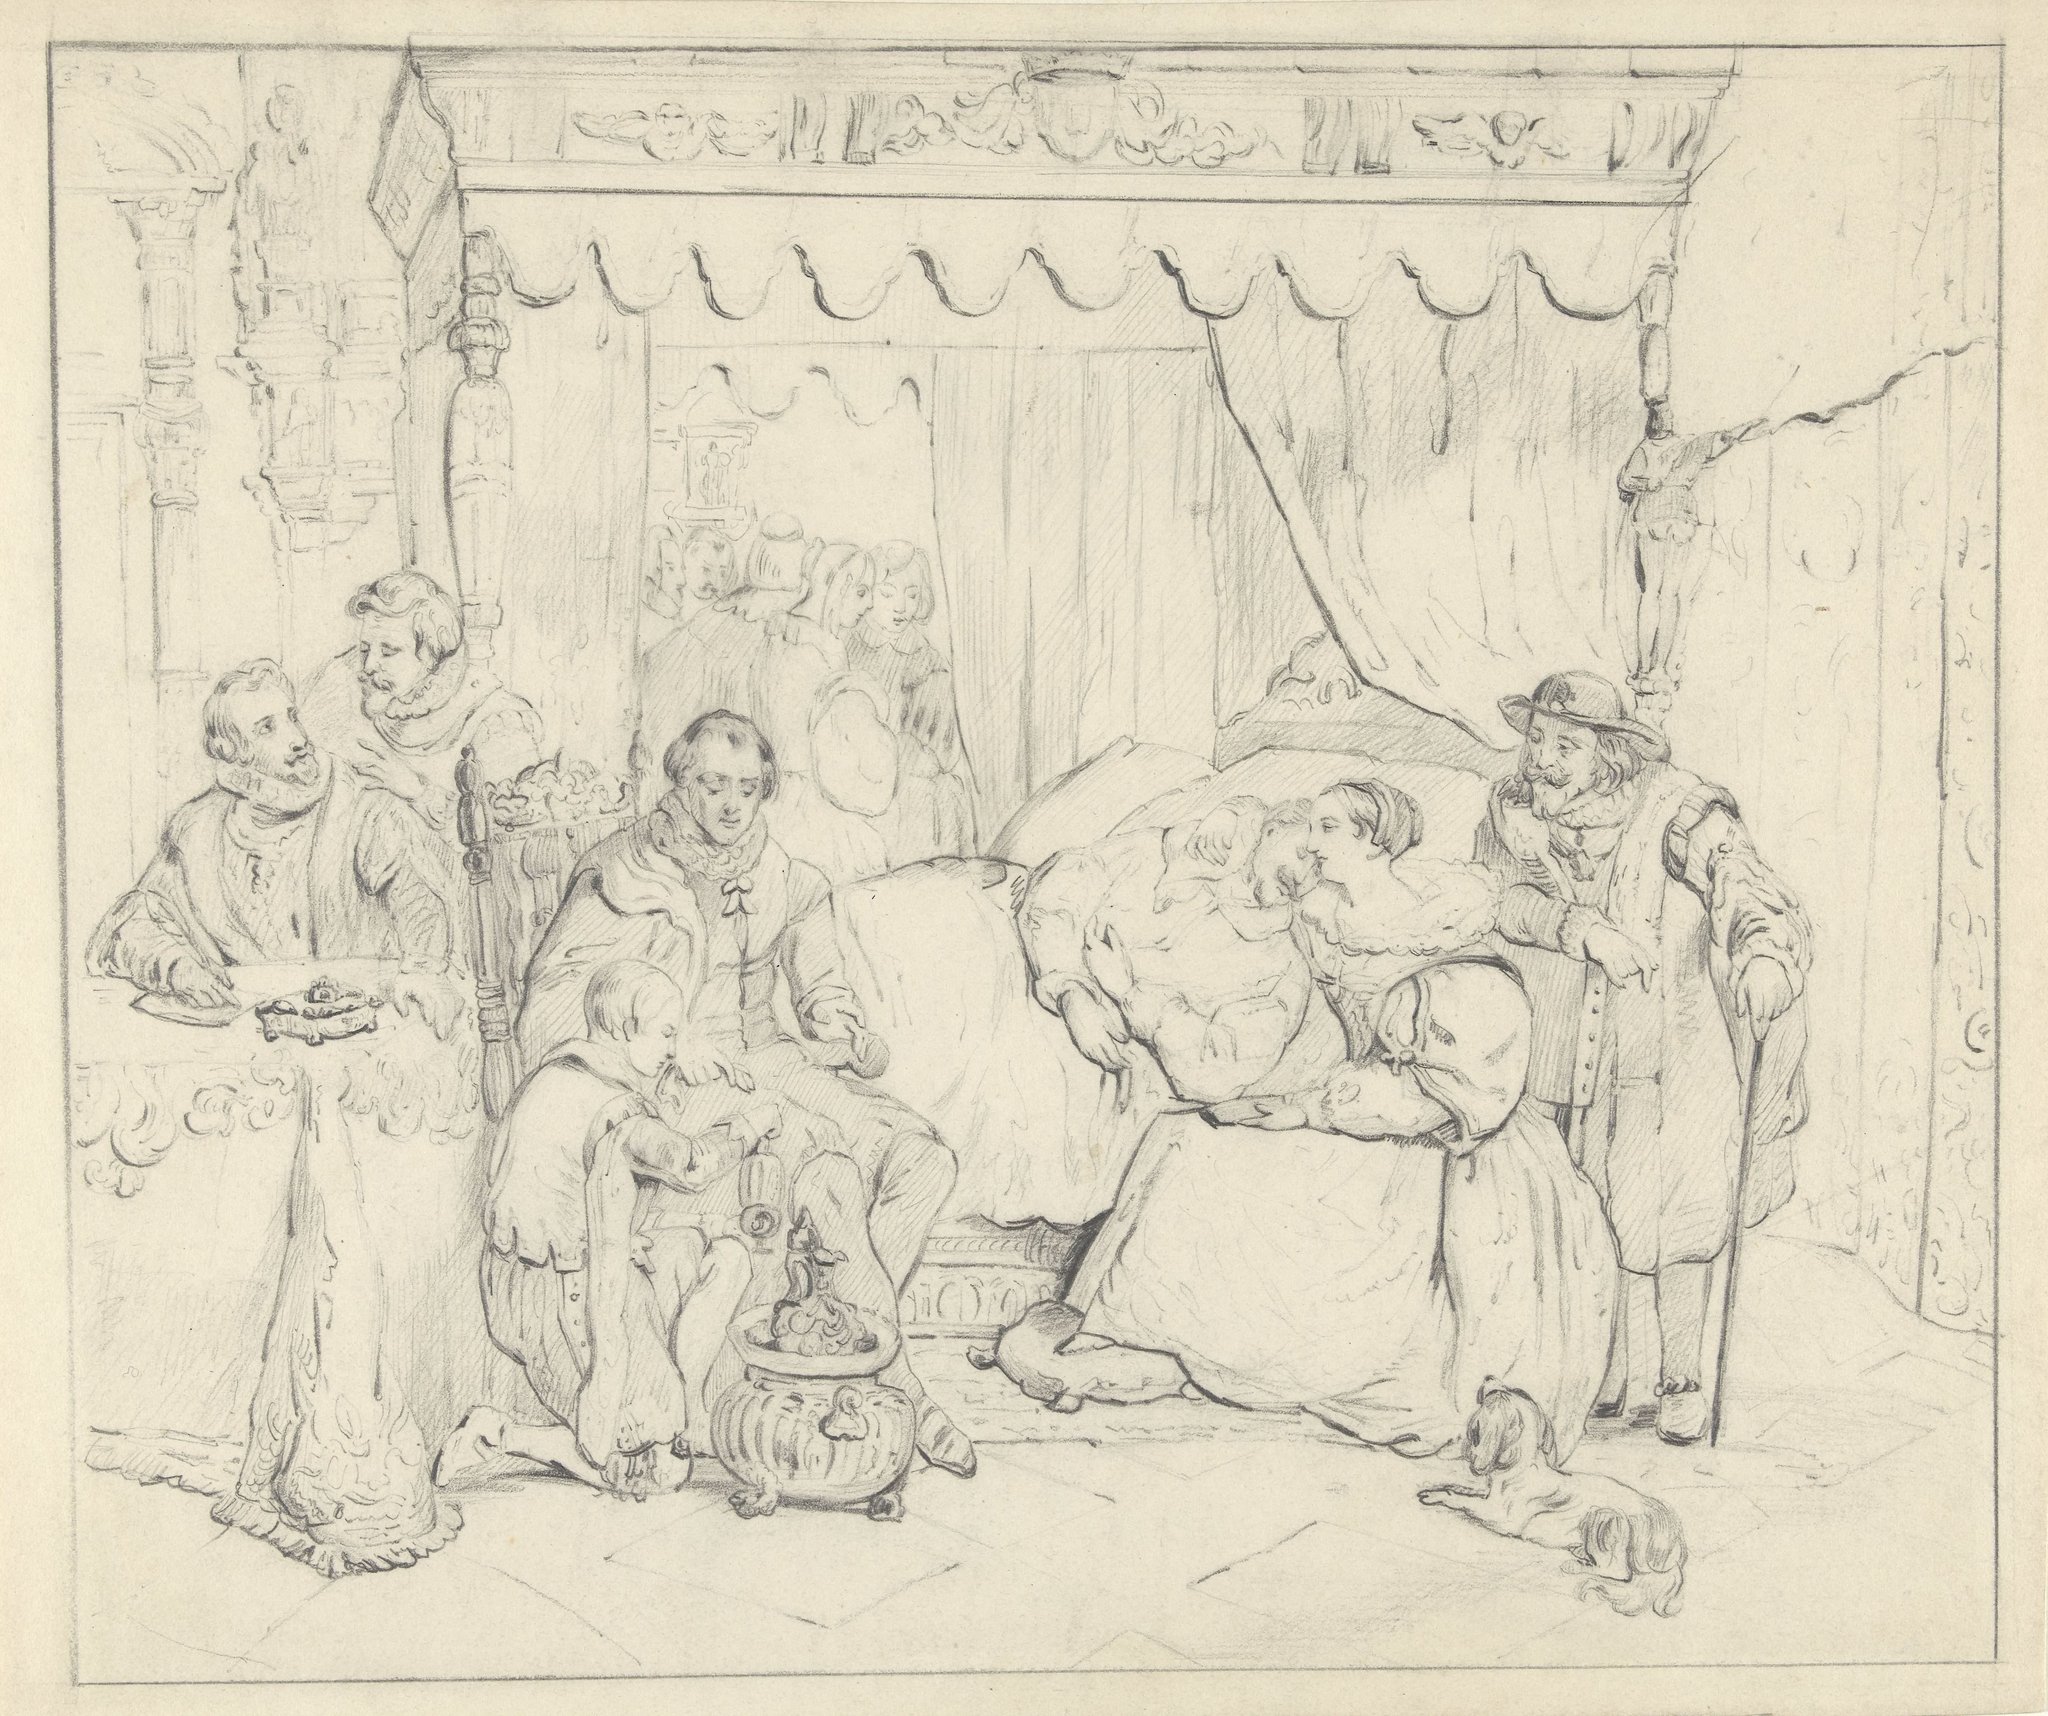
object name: drawing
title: Prins Willem I, na de mislukte moordaanslag door Jean Jauregui in 1582, verpleegd door Charlotte de Bourbon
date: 1840-1899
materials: paper, pencil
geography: netherlands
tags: antwerp, charlotte of bourbon, delft, william i (prince of orange), attempt, political murder, recovery, convalescence of sick person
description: Prins Willem I herstellend van de aanslag door Jean de Jauregui, gepleegd op 18 maart 1582, te Antwerpen. De prins liggend in bed verzorgd door artsen en getroost door zijn vrouw Charlotte de Bourbon.